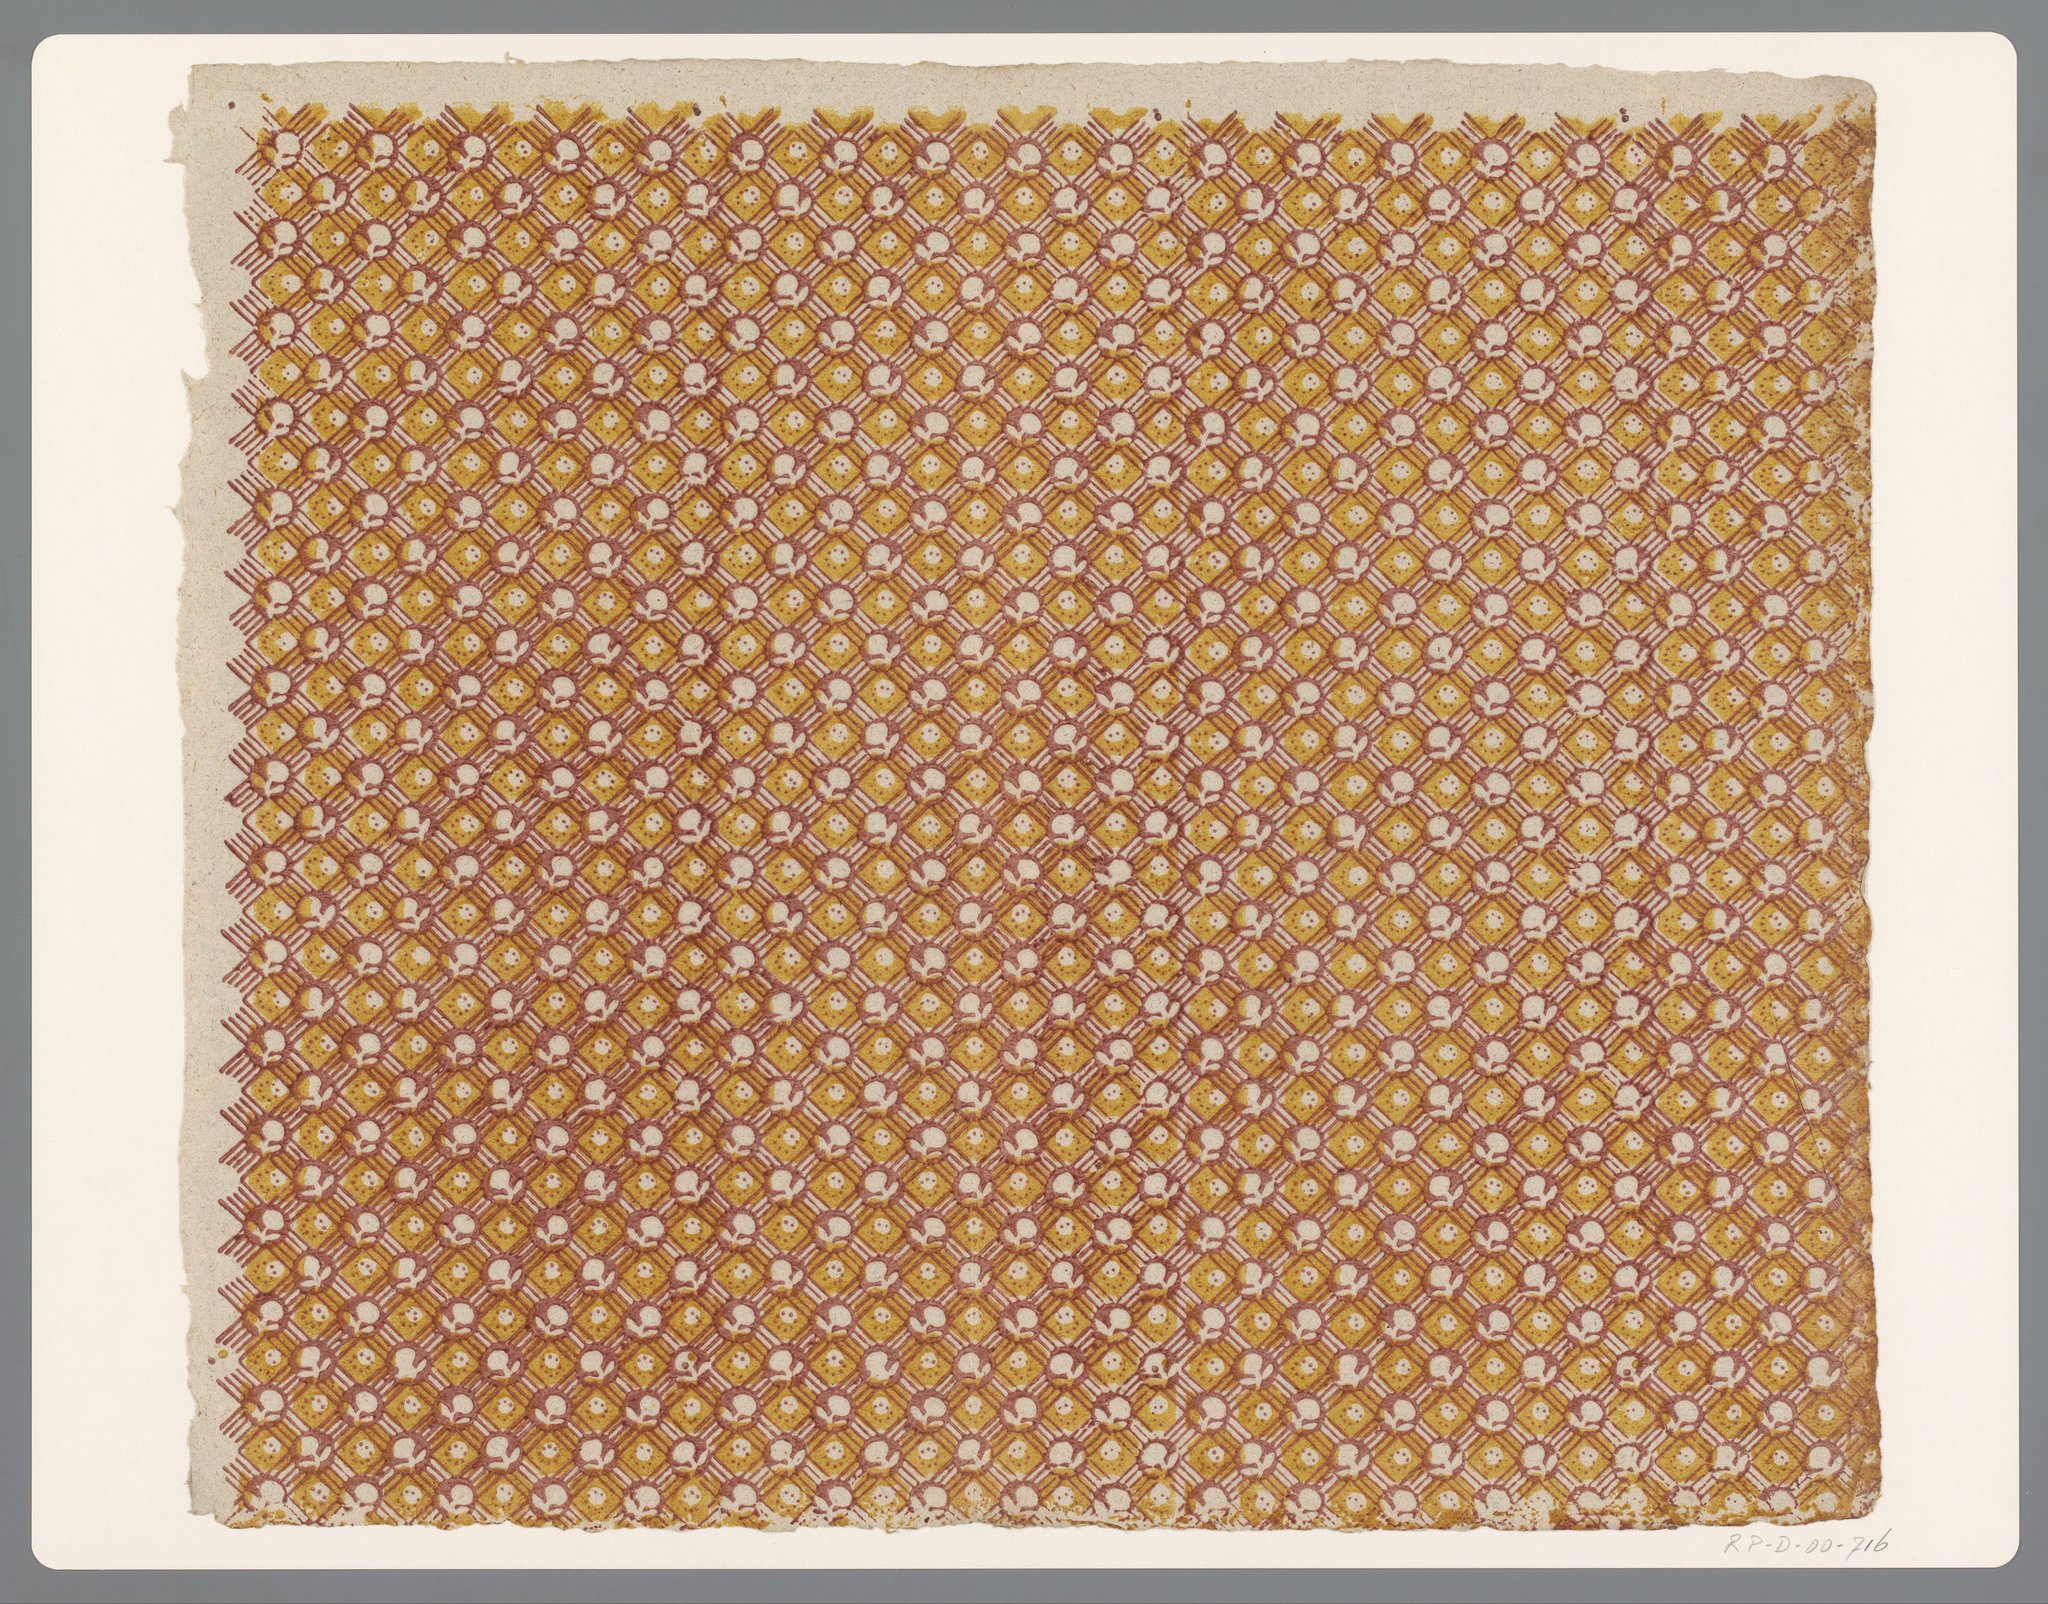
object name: printed paper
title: Blad met ruitenpatroon en bloemmotief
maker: Anonymous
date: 1750-1900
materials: paper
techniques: printing block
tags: ornament derived from plant forms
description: Blad met ruitenpatroon met overhoeks bloemmotief.